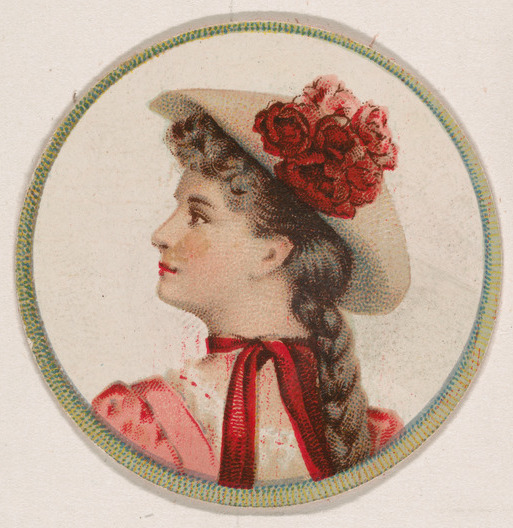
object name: print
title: Woman wearing floral hat, from the Novelties series (N228, Type 2) issued by Kinney Bros.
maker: kinney brothers tobacco company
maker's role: publisher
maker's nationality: american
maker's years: 1869-2011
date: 1889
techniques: color lithograph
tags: profiles,women